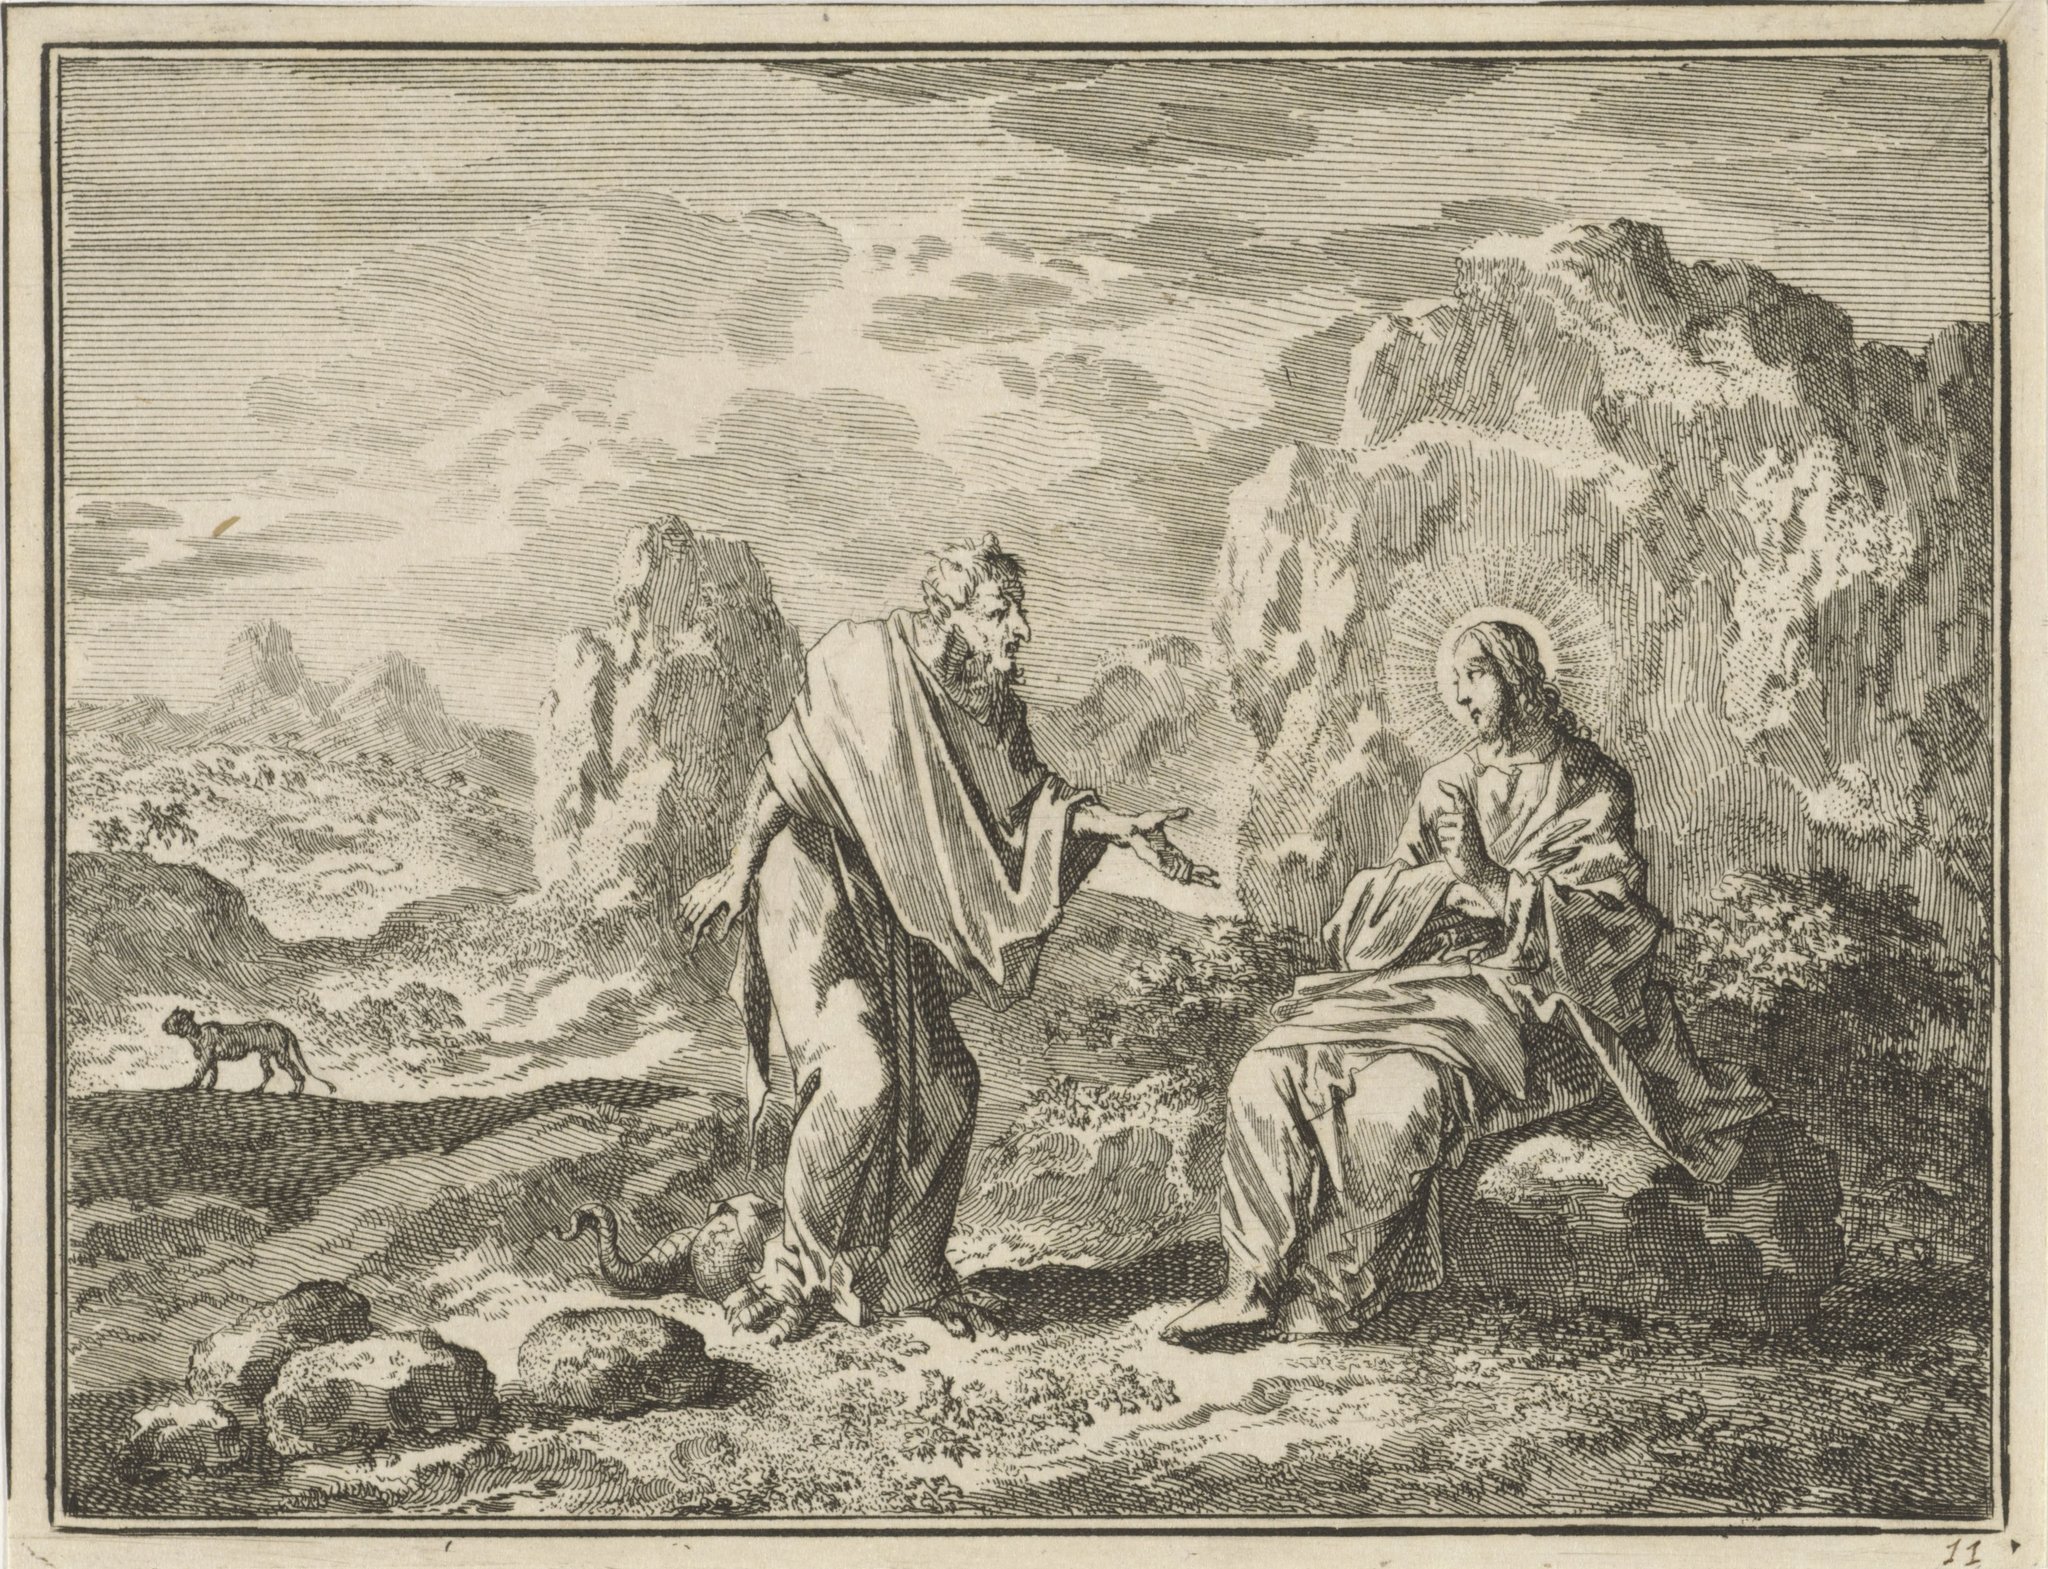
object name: print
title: Verzoeking van Christus in de woestijn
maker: jan luyken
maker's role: draughtsman, print maker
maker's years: 1649-1712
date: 1712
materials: paper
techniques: etching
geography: amsterdam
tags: christ, sometimes accompanied by guardian angel(s), tempted by satan, who usually appears in human form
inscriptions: collector's mark: Lugt 2228, number: ‘11’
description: Proefdruk van illustratie uit: Luyken, Jan. De schriftuurlyke geschiedenissen en gelykenissen van het Oude en Nieuwe Verbond, 2 delen. Amsterdam: Wed. Pieter Arentsz II en Cornelis van der Sys, 1712, dl. II.